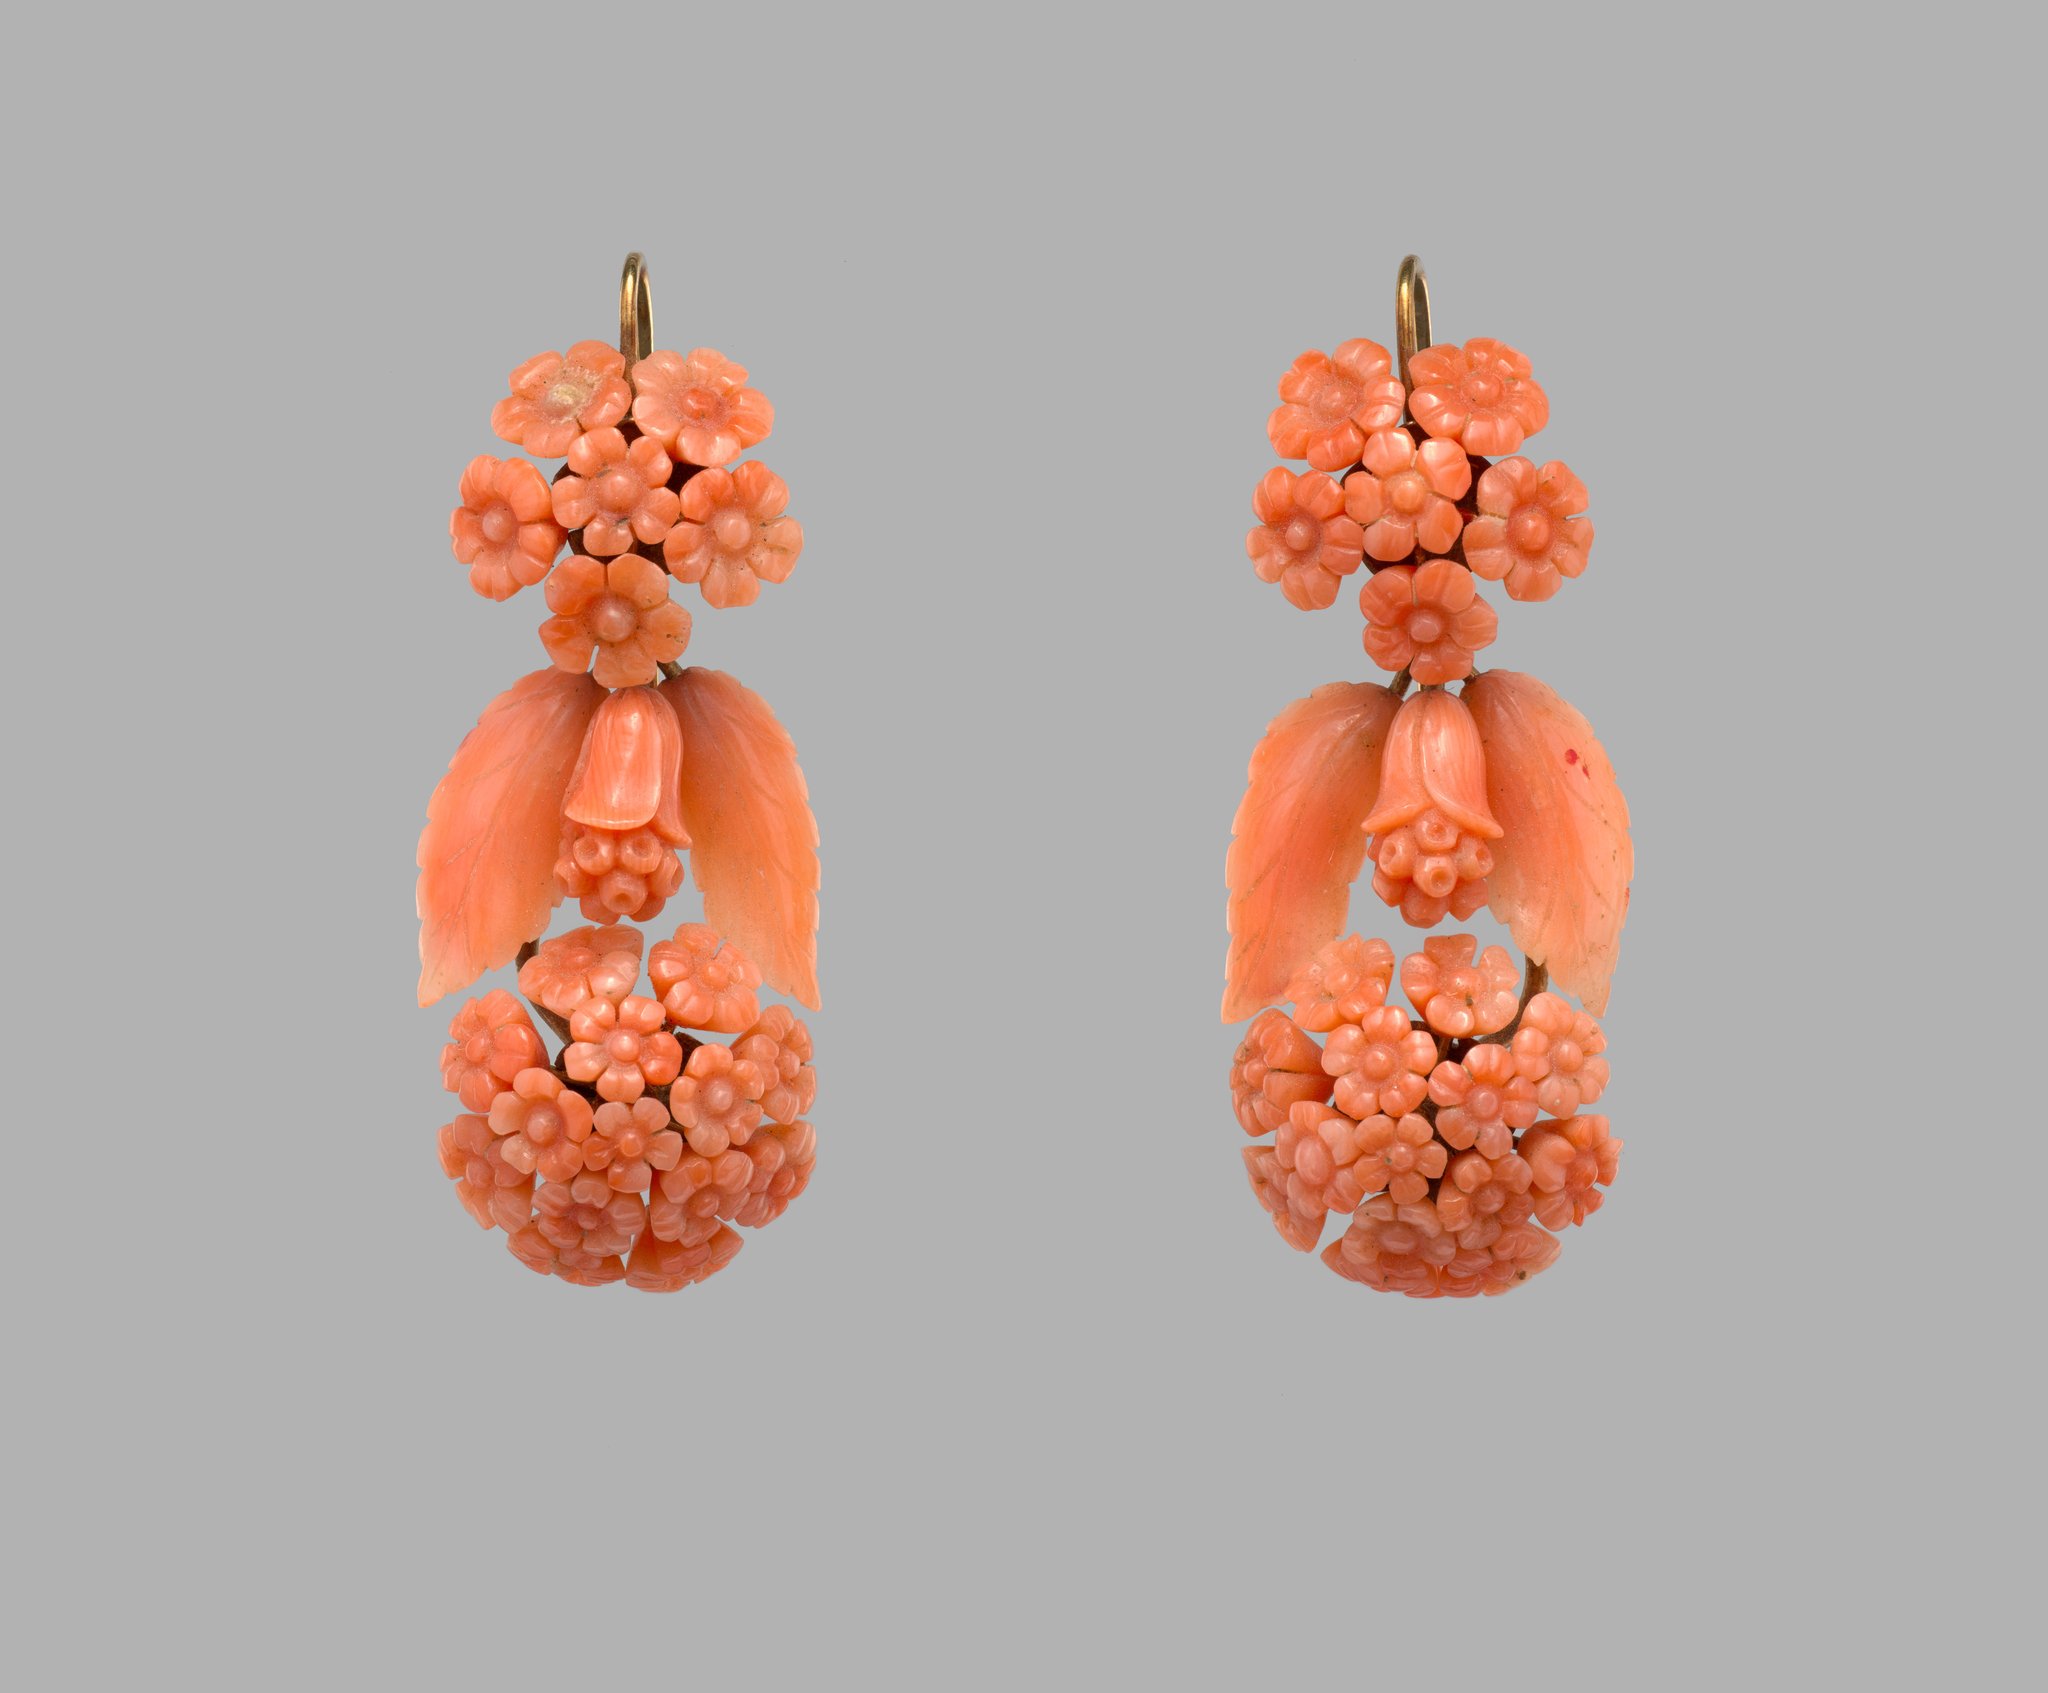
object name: earring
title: Earring (part of parure)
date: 1860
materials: coral, gold